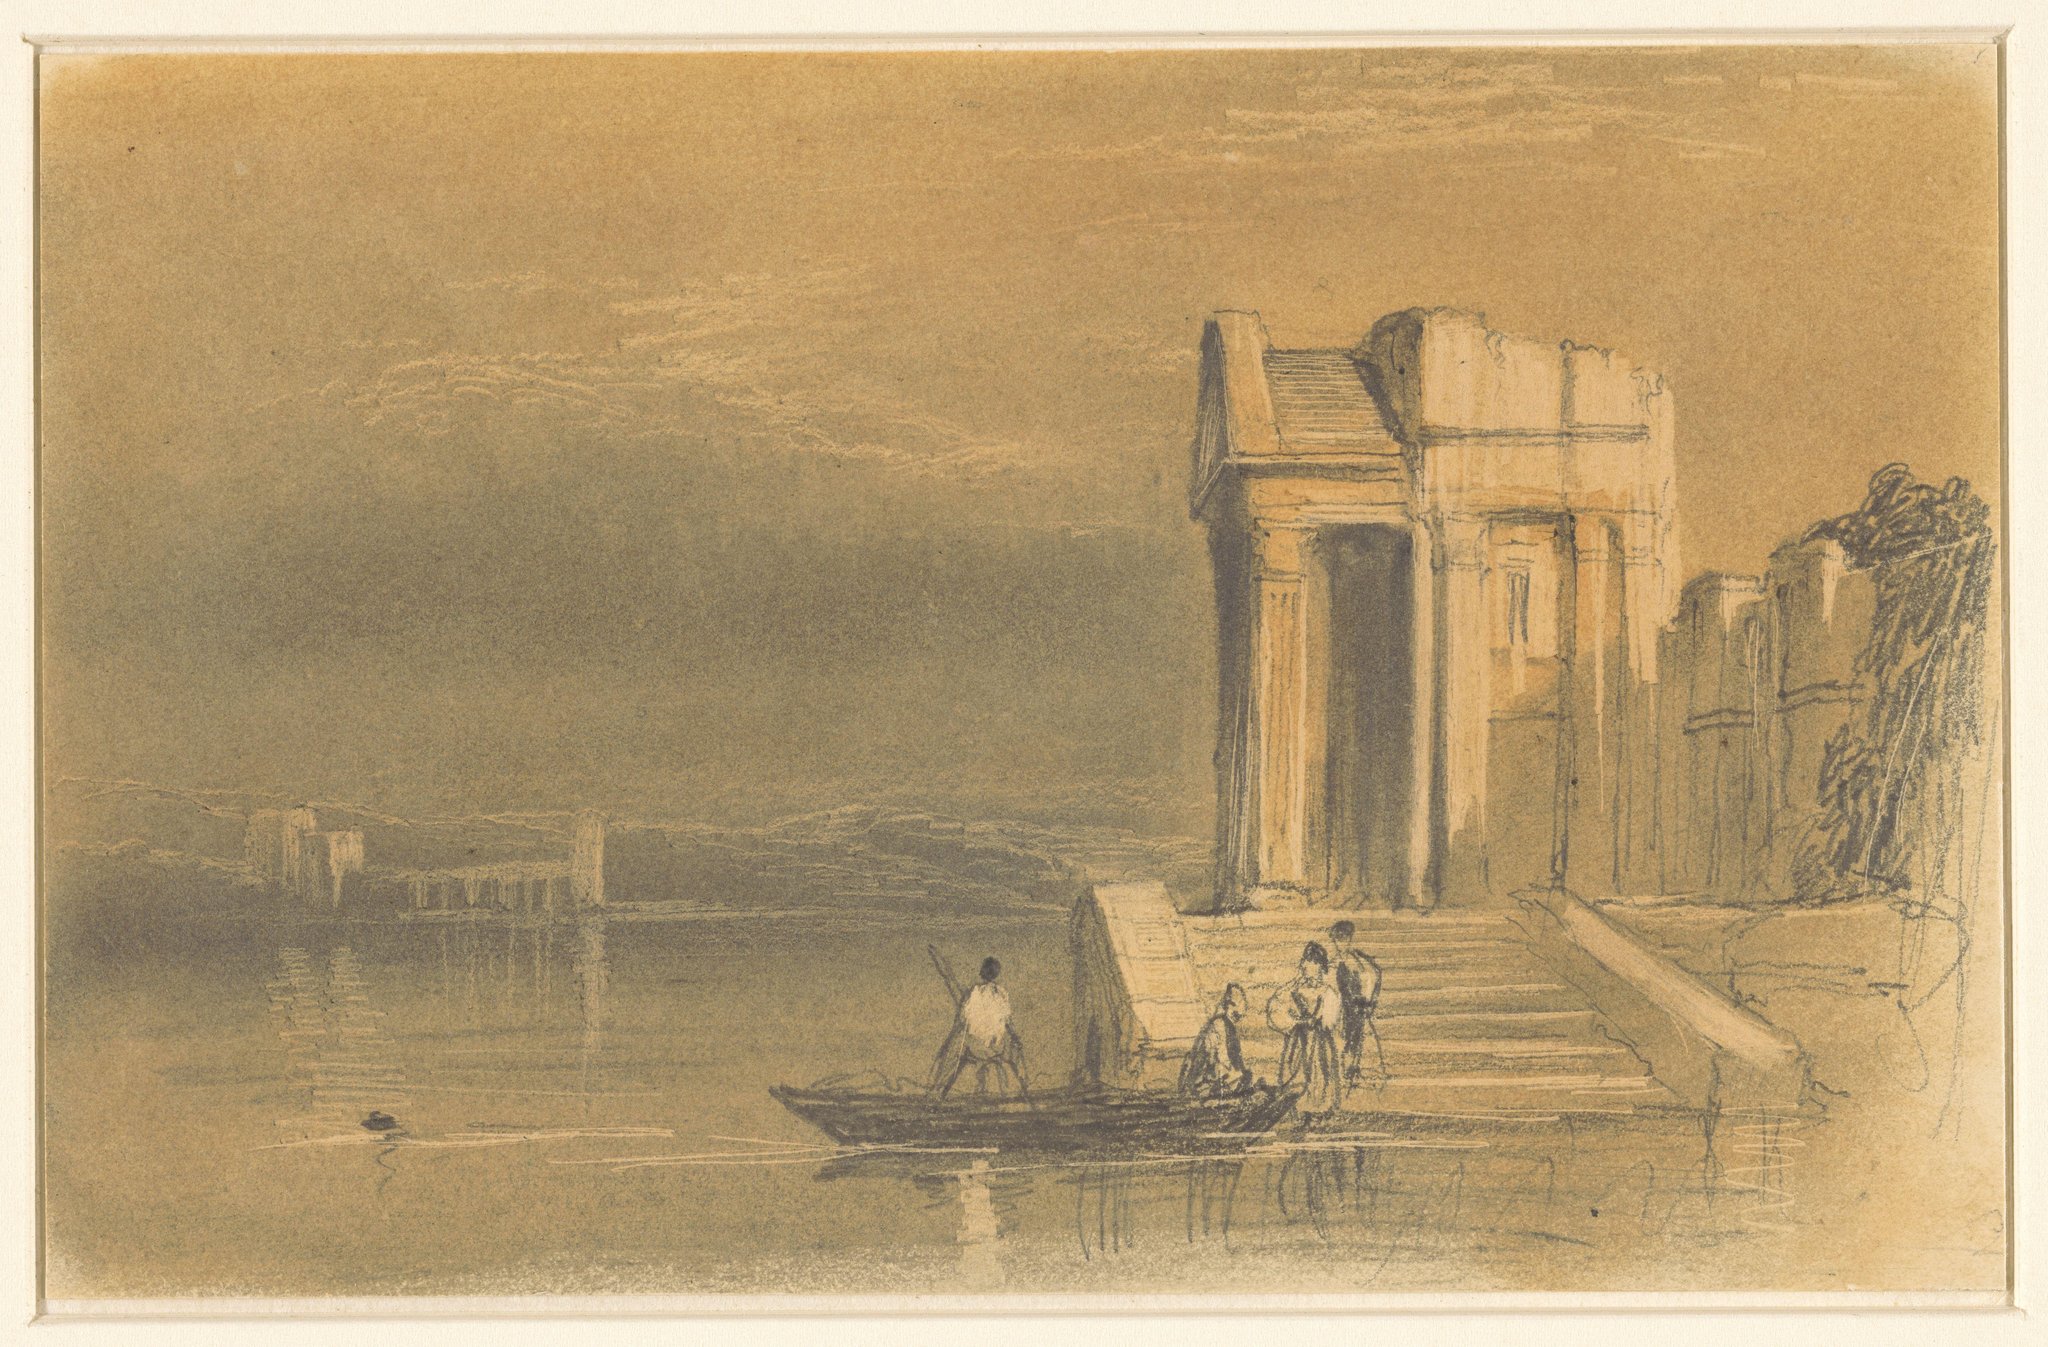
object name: drawing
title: Tempelruïnes aan een meer in een Italiaans landschap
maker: clarkson frederick stanfield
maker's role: draughtsman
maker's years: 1793-1867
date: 1803-1867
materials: paper, pencil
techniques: scratching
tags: landscape with ruins, lake (+ landscape with figures, staffage)